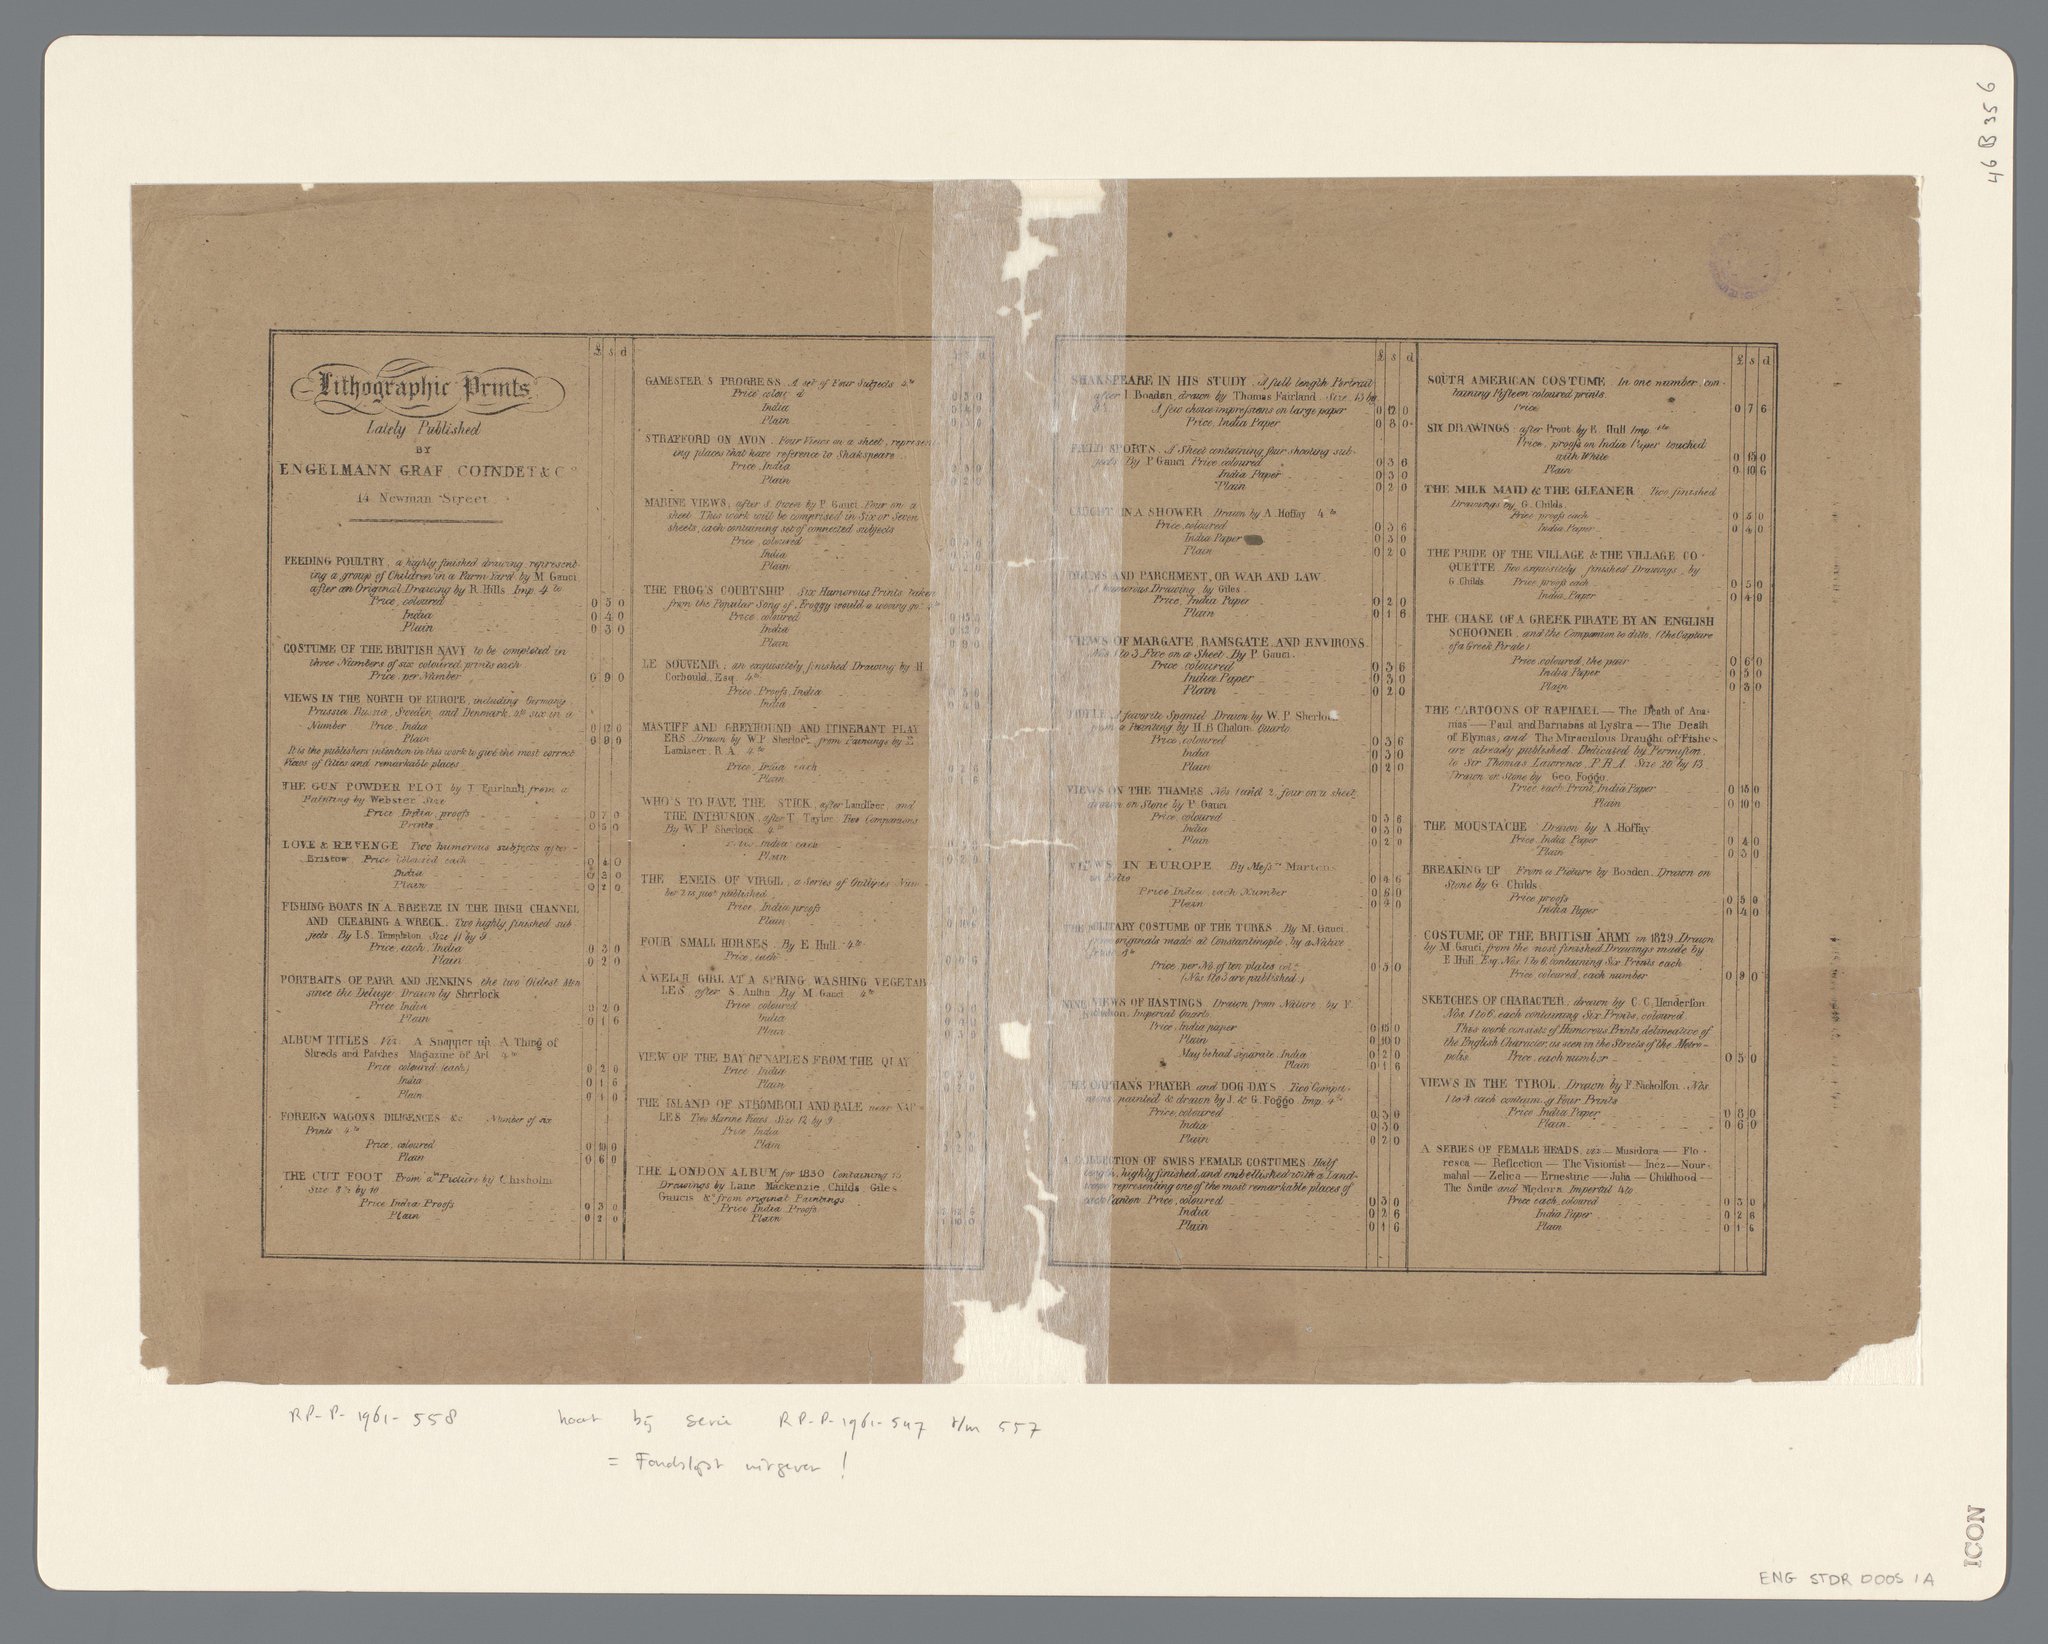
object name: print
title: The Neapolitan Costume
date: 1830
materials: paper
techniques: hand coloring, lithograph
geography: london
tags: folk costume, regional costume, mother and child(ren), woman and child(ren) (family group), europeans (with name)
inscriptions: collector's mark: Lugt 2228, mark: ‘School voor de grafische vakken te Utrecht’